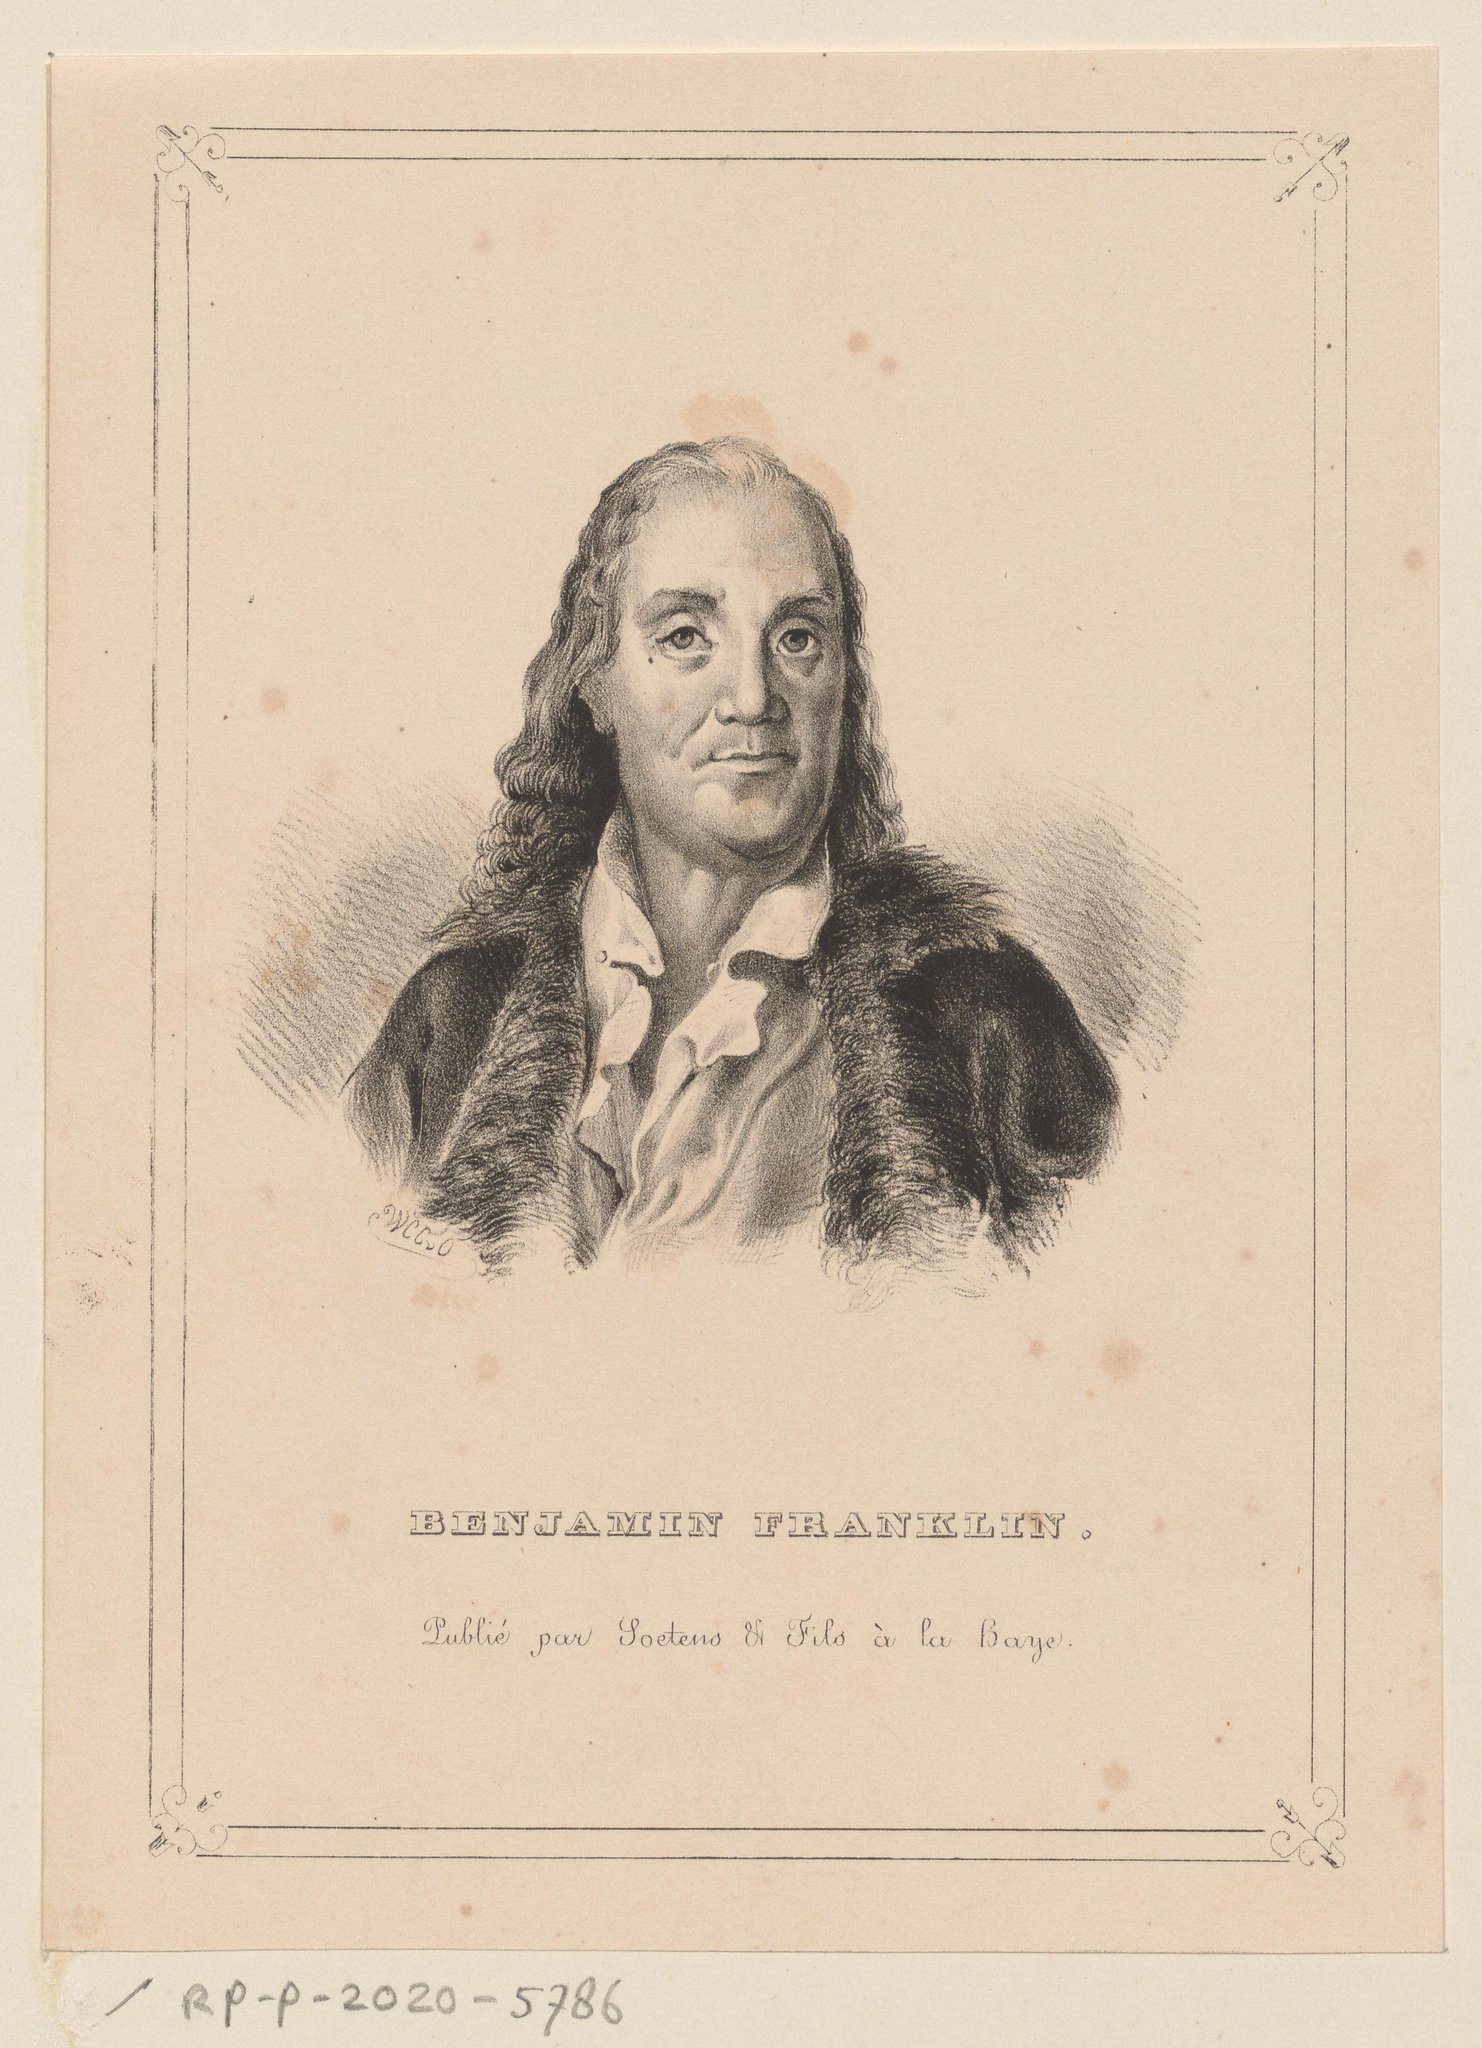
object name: print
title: Portret van Benjamin Franklin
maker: Anonymous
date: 1837-1840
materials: paper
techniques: lithograph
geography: the hague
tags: historical persons, politician, e.g. party leader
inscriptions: monogram: ‘WCCvO’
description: Deze prent maakte vermoedelijk deel uit van een serie uitgegeven door Soetens & Fils omstreeks 1838, opgedragen aan de Prins van Oranje. In de 'Prospectus en Inteekenlijst' stond vermeld dat het zal bestaan uit een onbepaald aantal portretten, waarvan er drie of vier per maand verschijnen. Zie Van Someren.